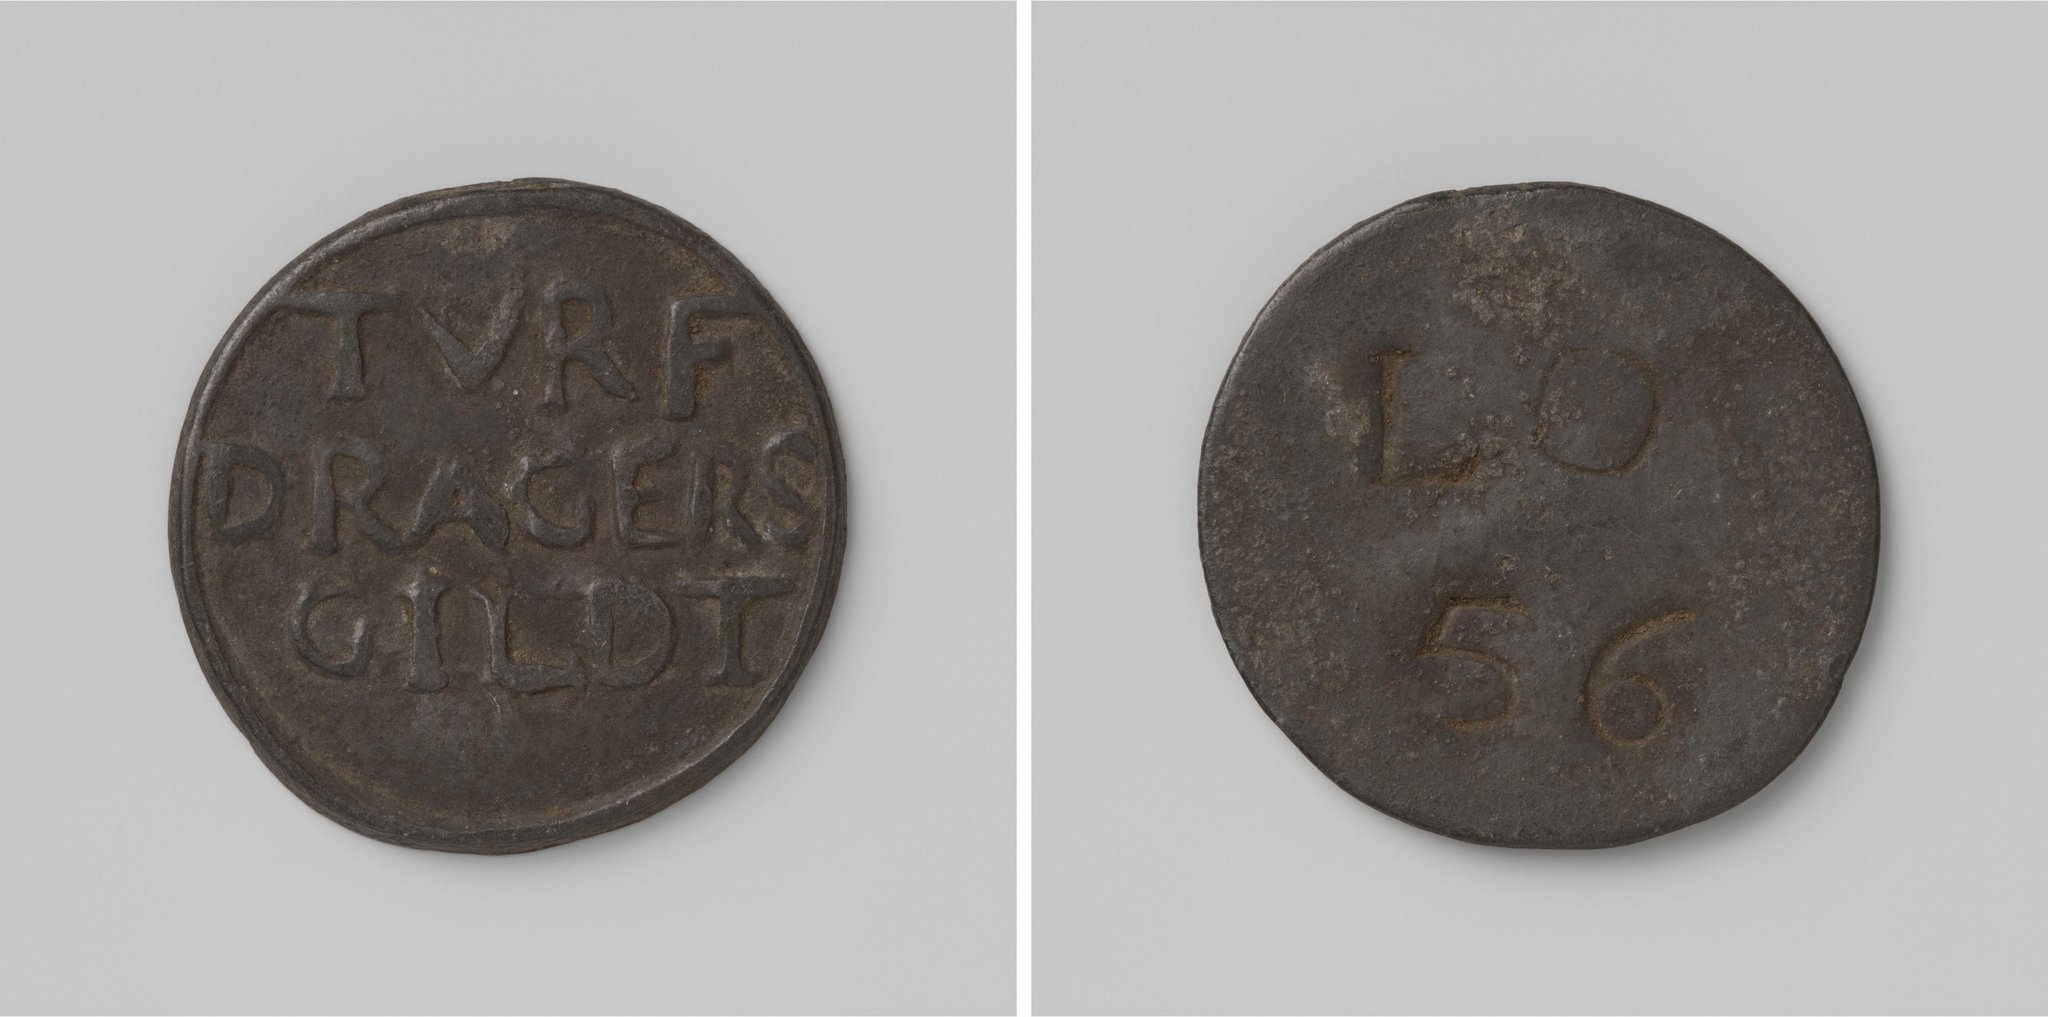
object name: medal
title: Turfdragersgilde van Amsterdam, gildepenning met L.O. 56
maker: Anonymous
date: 1600-1800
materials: lead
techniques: casting, engraving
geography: amsterdam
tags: amsterdam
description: Loden penning. Voorzijde: opschrift. Keerzijde: letters L.O. boven cijfer 56